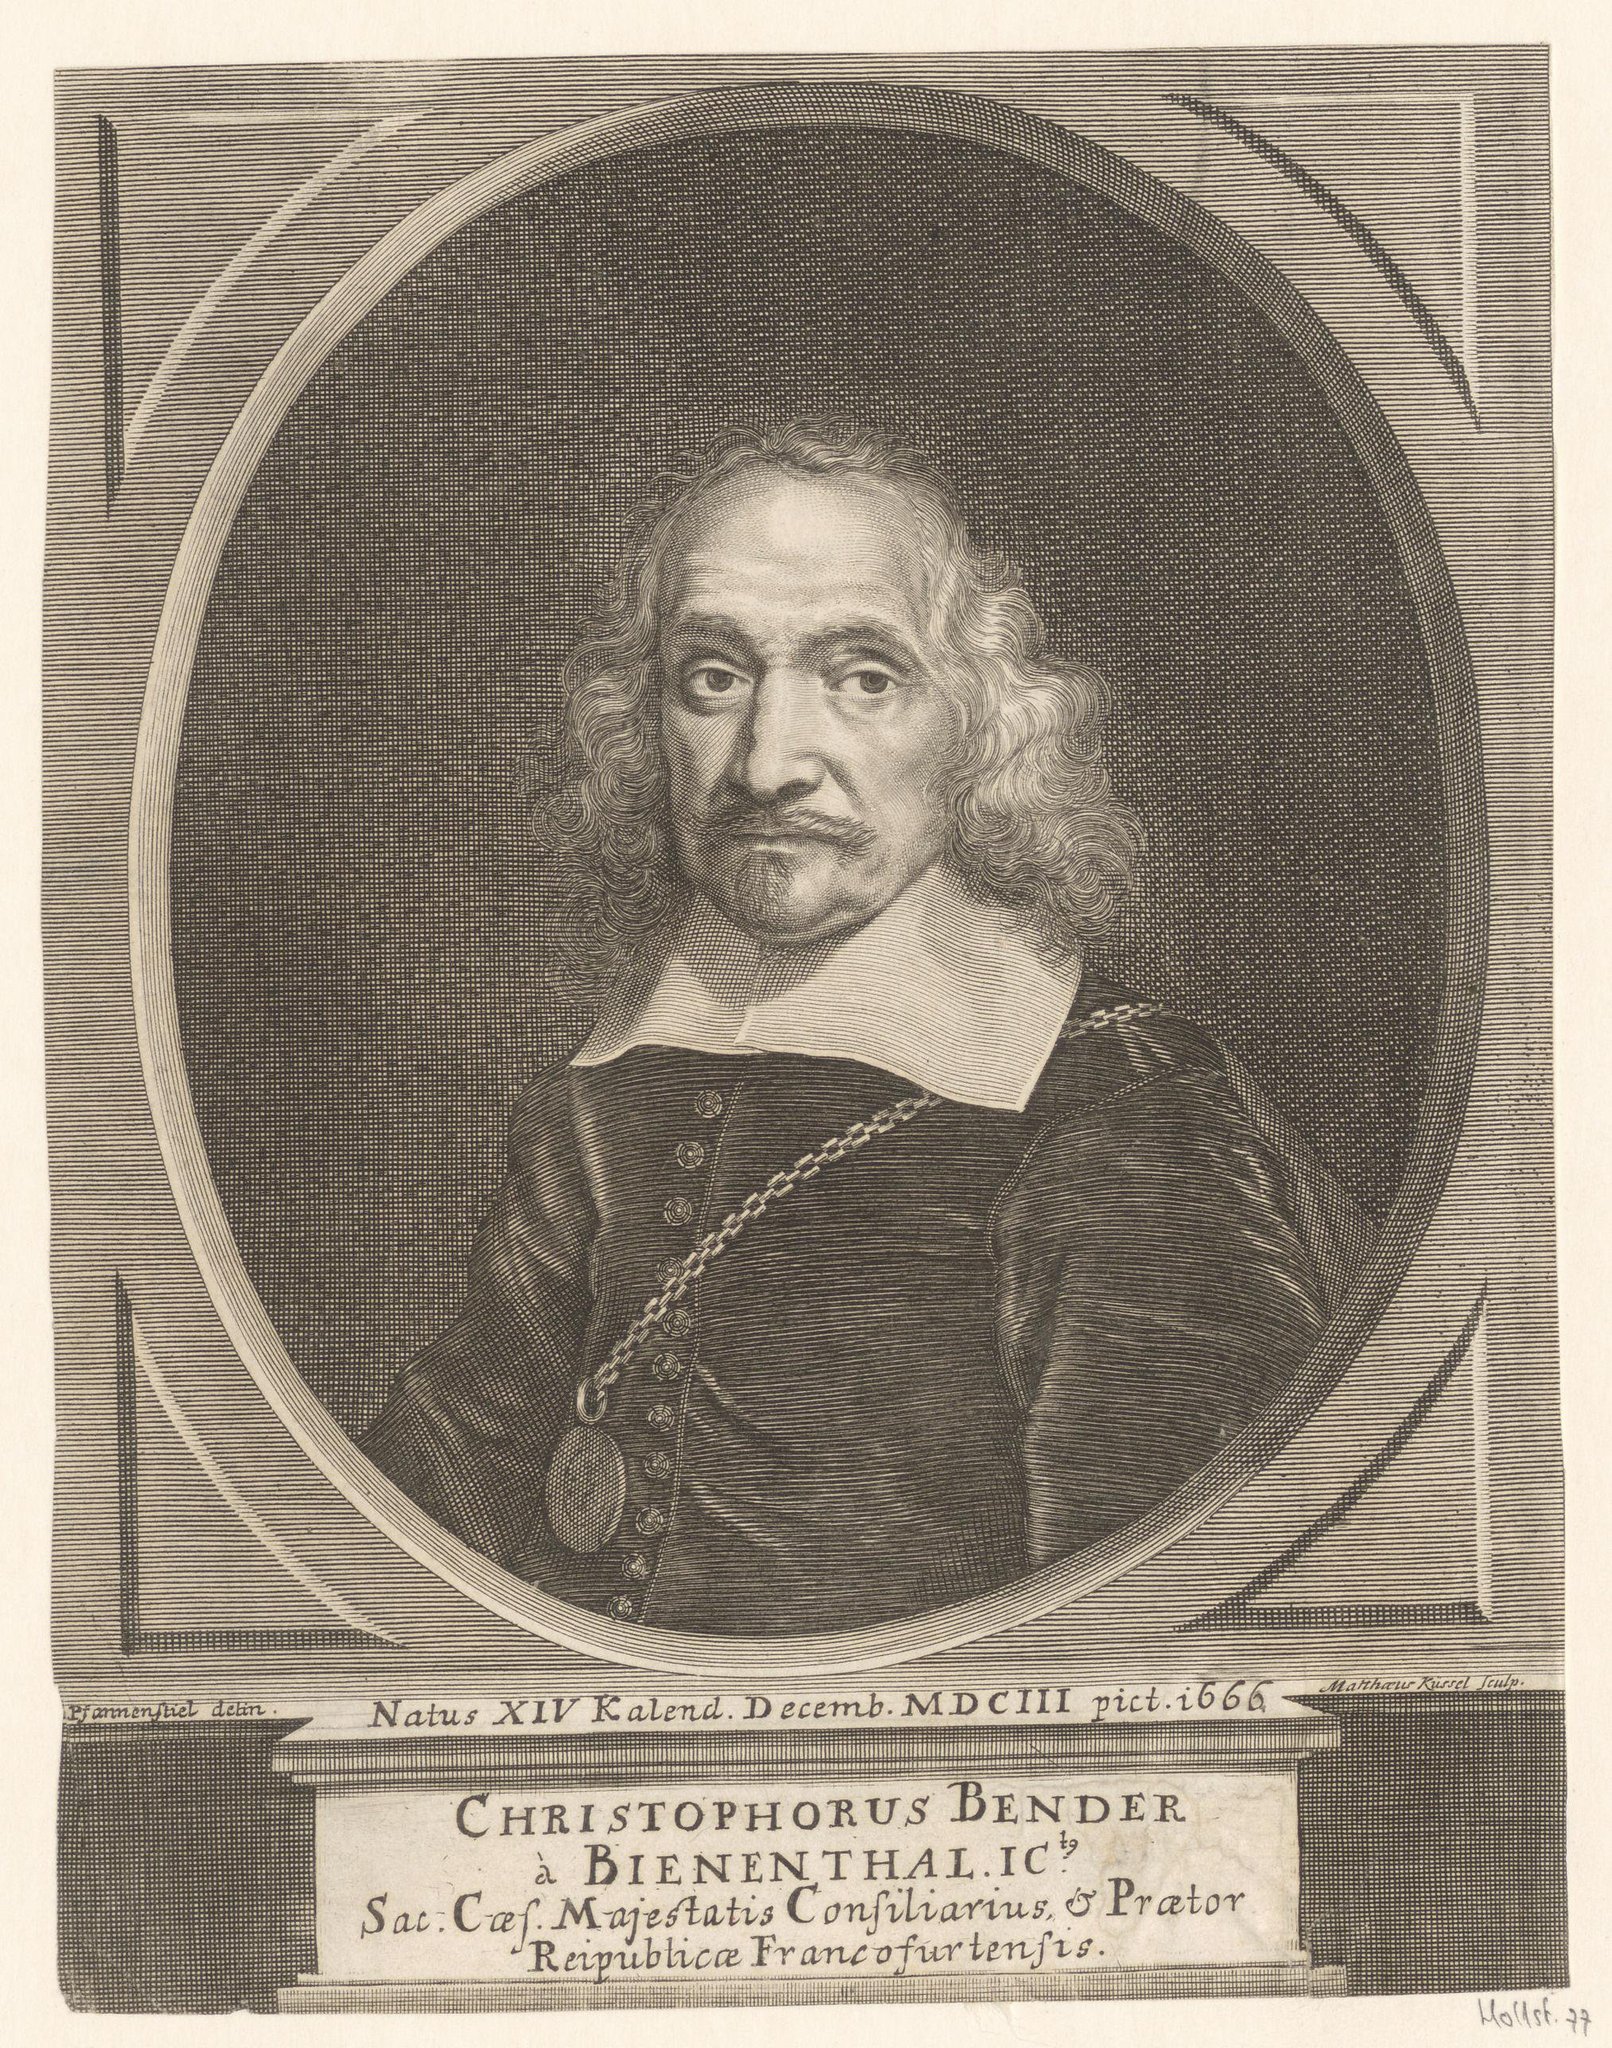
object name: print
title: Portret van Christoph Bender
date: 1666-1681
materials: paper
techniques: engraving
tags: historical persons, politician, e.g. party leader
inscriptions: collector's mark: Lugt 2228